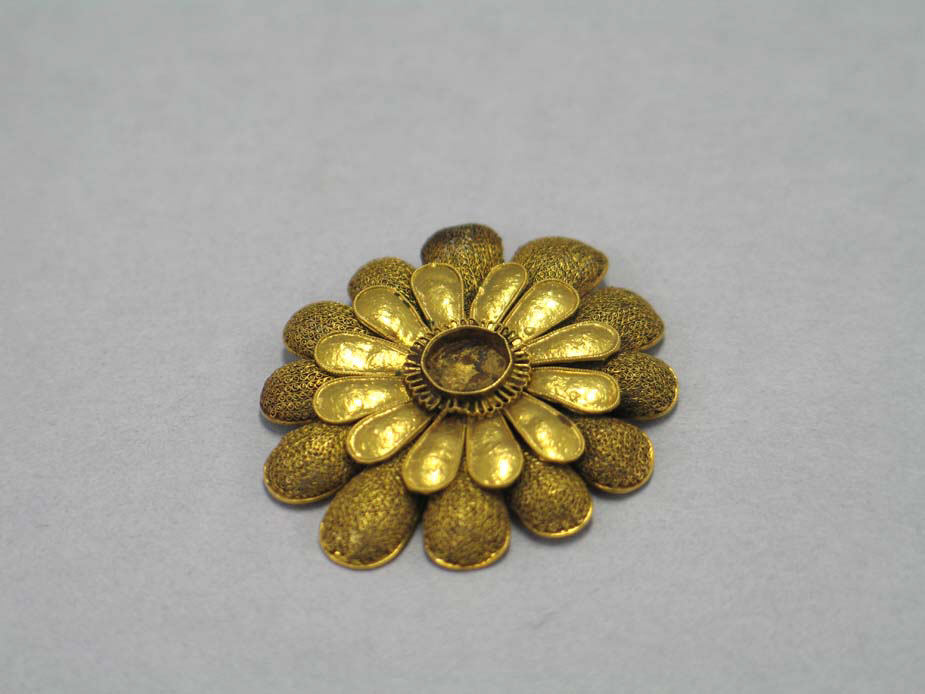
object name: ornament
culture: chinese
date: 960-1279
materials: gold